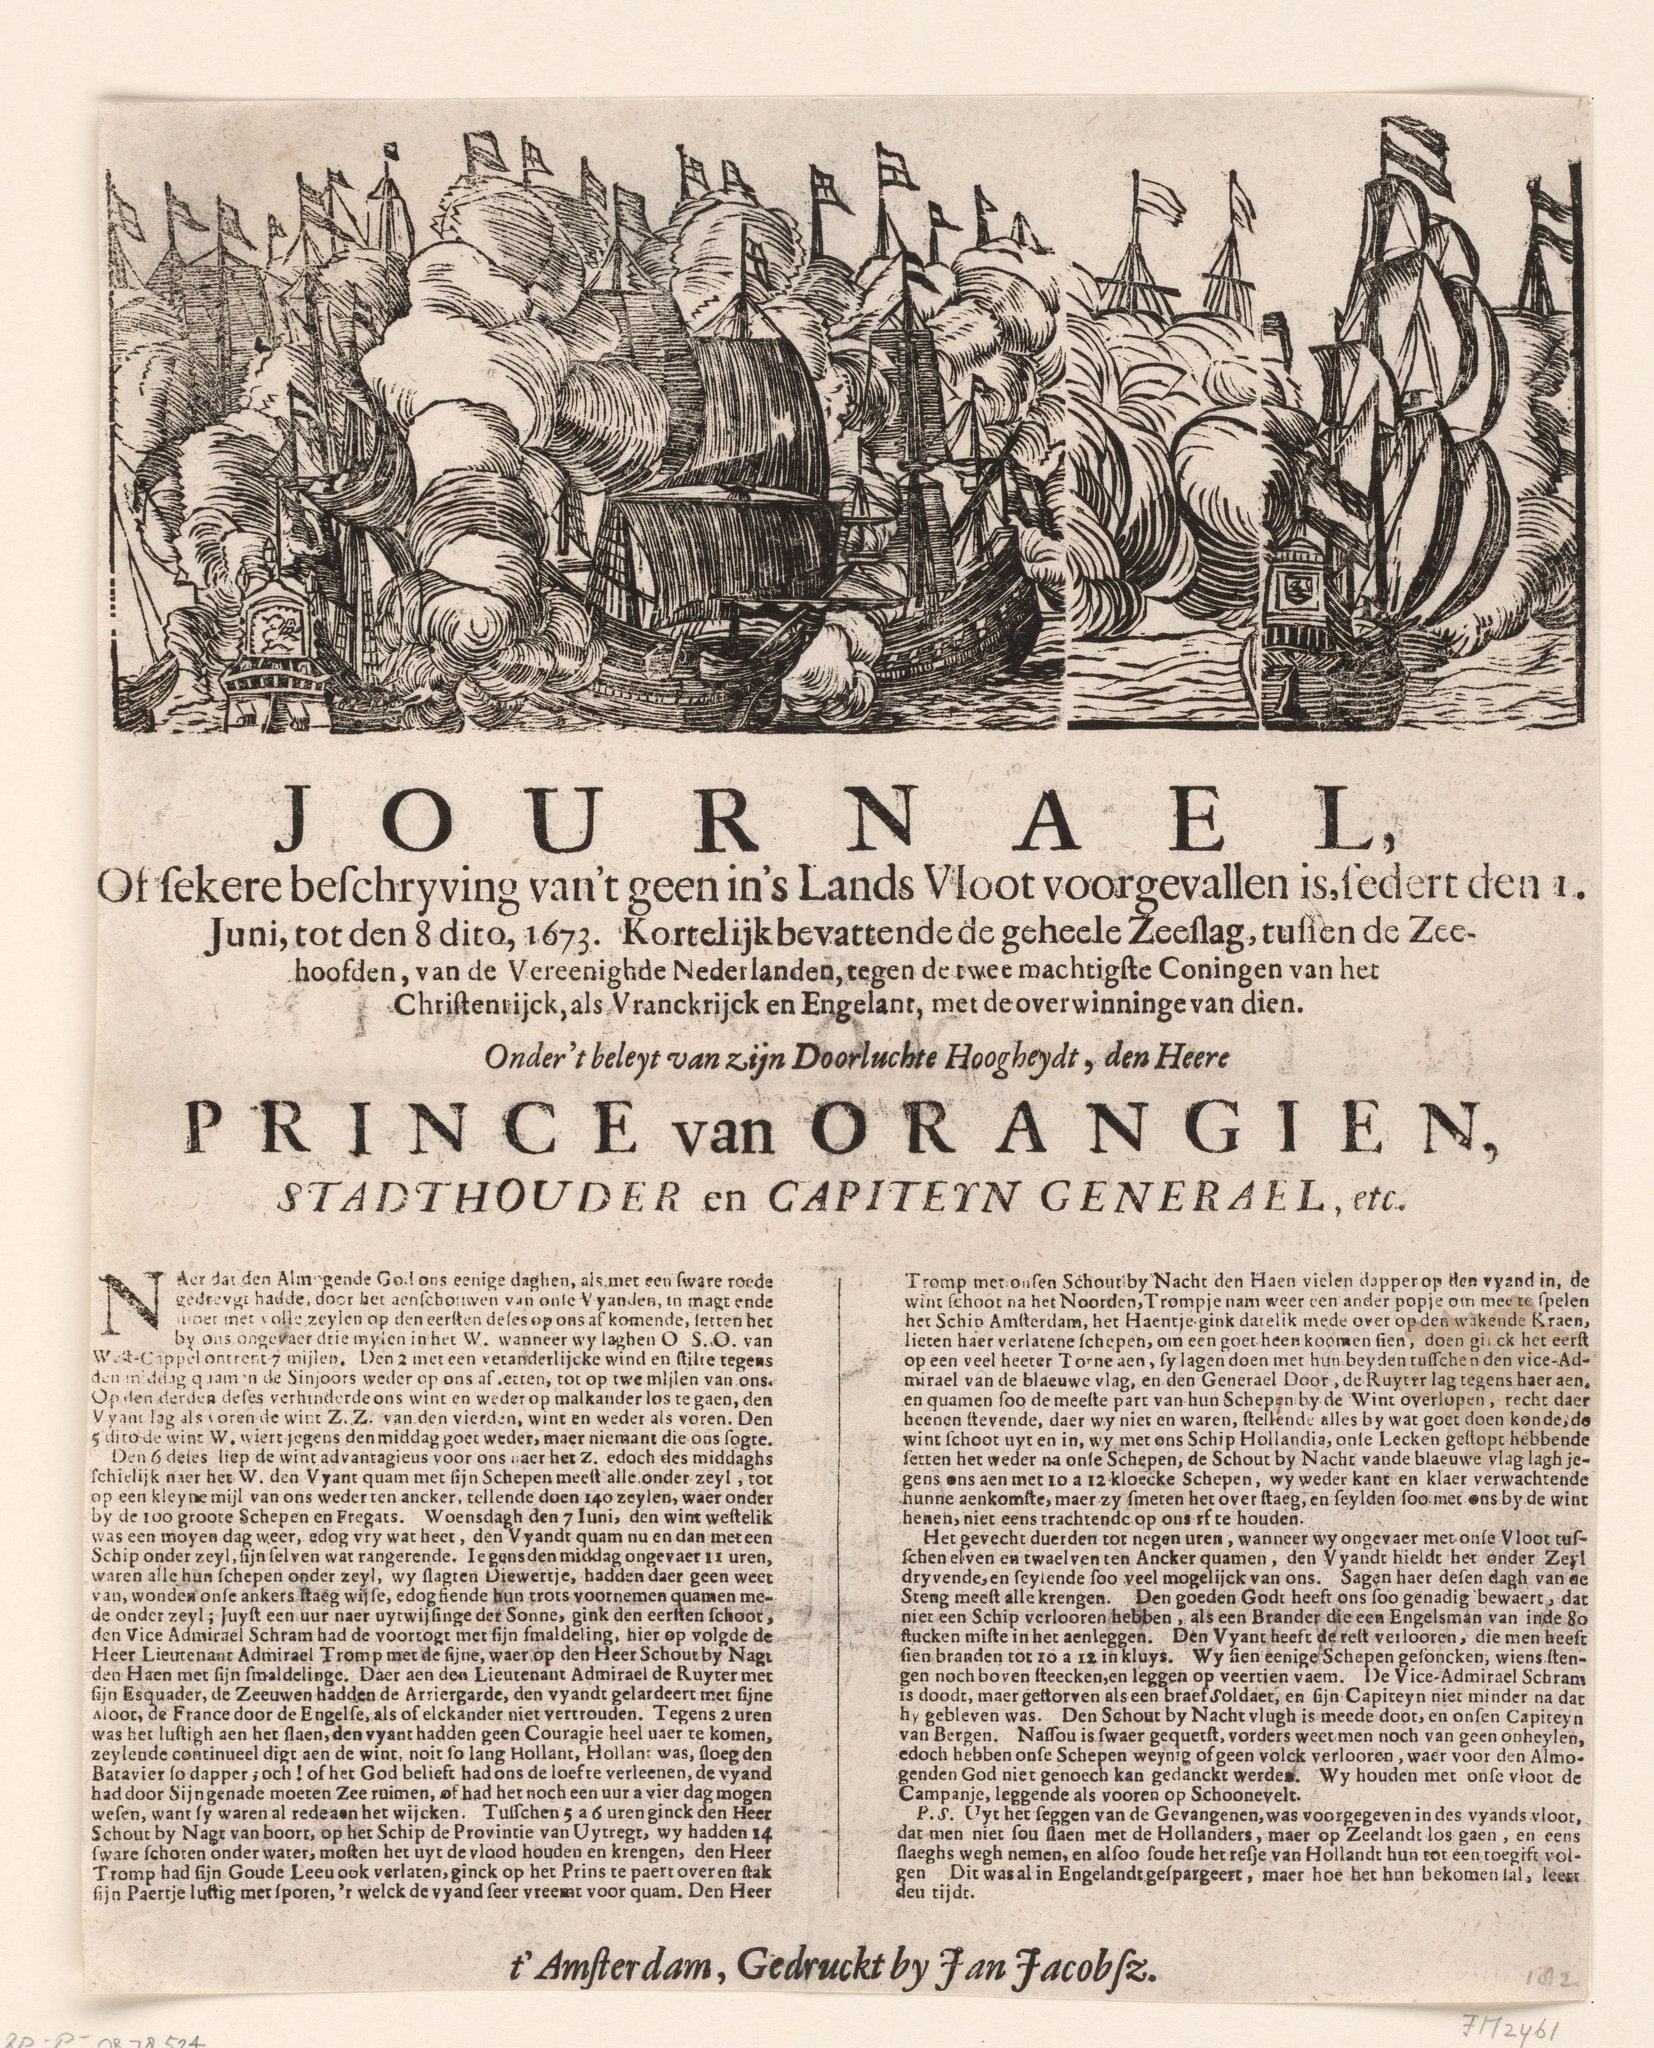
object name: print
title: Journael, Of sekere beschryving van 't geen in 's Lands Vloot voorgevallen is, sedert den 1. Juni, tot den 8 dito, 1673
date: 1673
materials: paper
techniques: letterpress printing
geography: northern netherlands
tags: battle (+ naval force), first battle of schooneveld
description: Blad met voorstelling en beschrijving van de eerste zeeslag op Schoonevelt van de Staatse vloot onder Michiel de Ruyter en Cornelis Tromp tegen de Engelsen en de Fransen op 7 juni 1673.